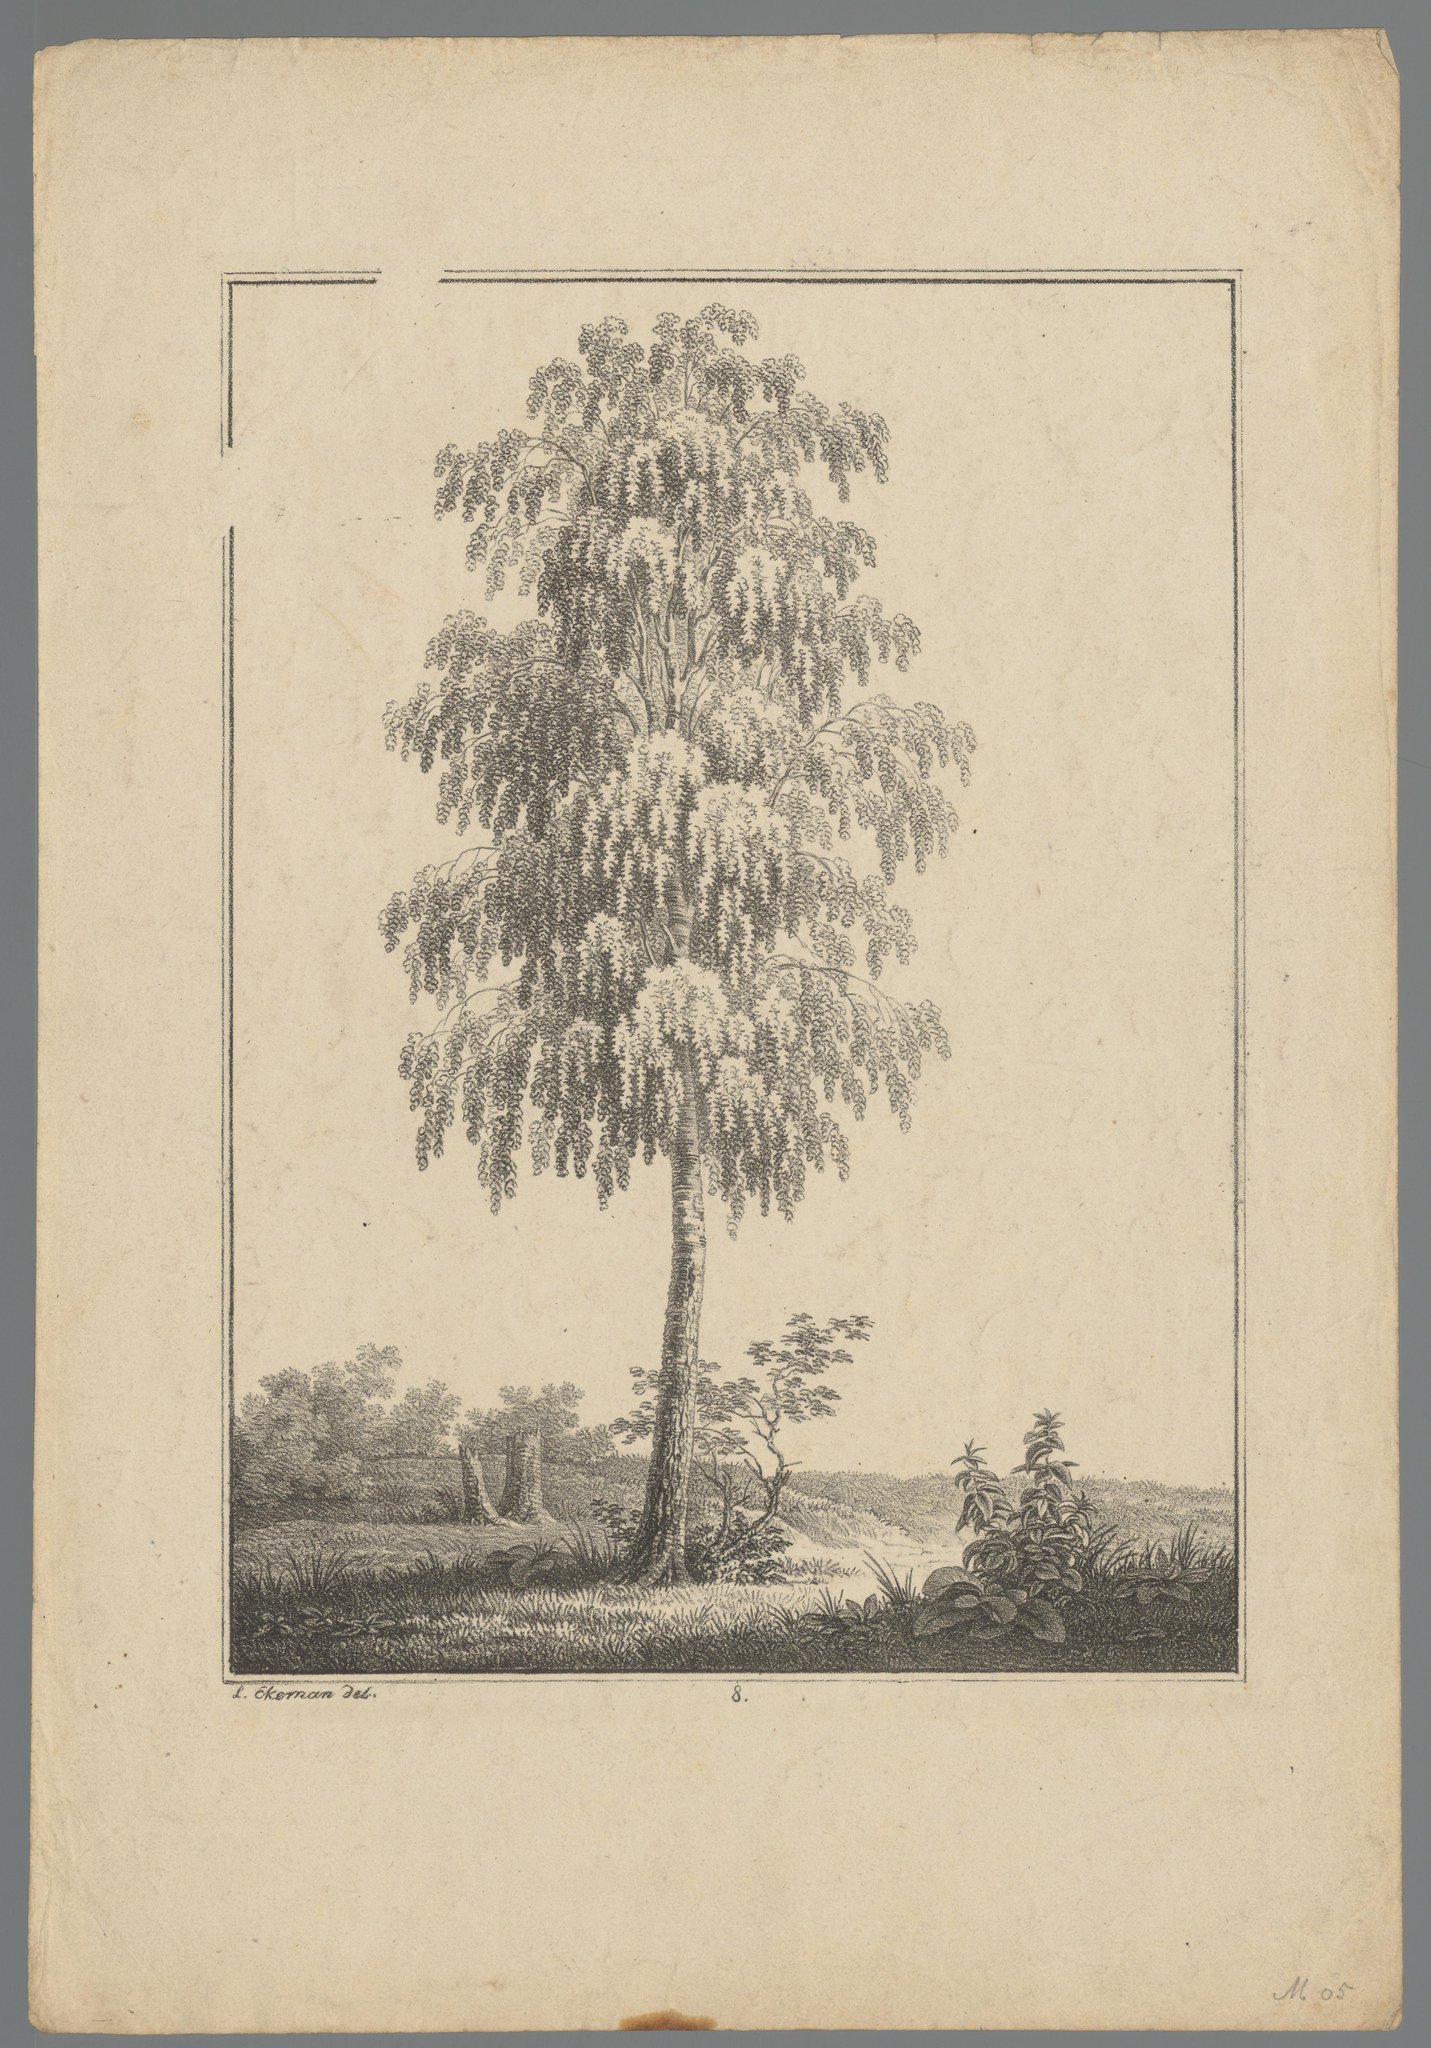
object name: print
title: Boom- en landschapsstudies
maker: lorenz ekeman-allesson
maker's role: print maker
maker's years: 1791-1828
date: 1801-1828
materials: paper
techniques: lithograph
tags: trees, landscapes in the temperate zone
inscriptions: collector's mark: Lugt 2228